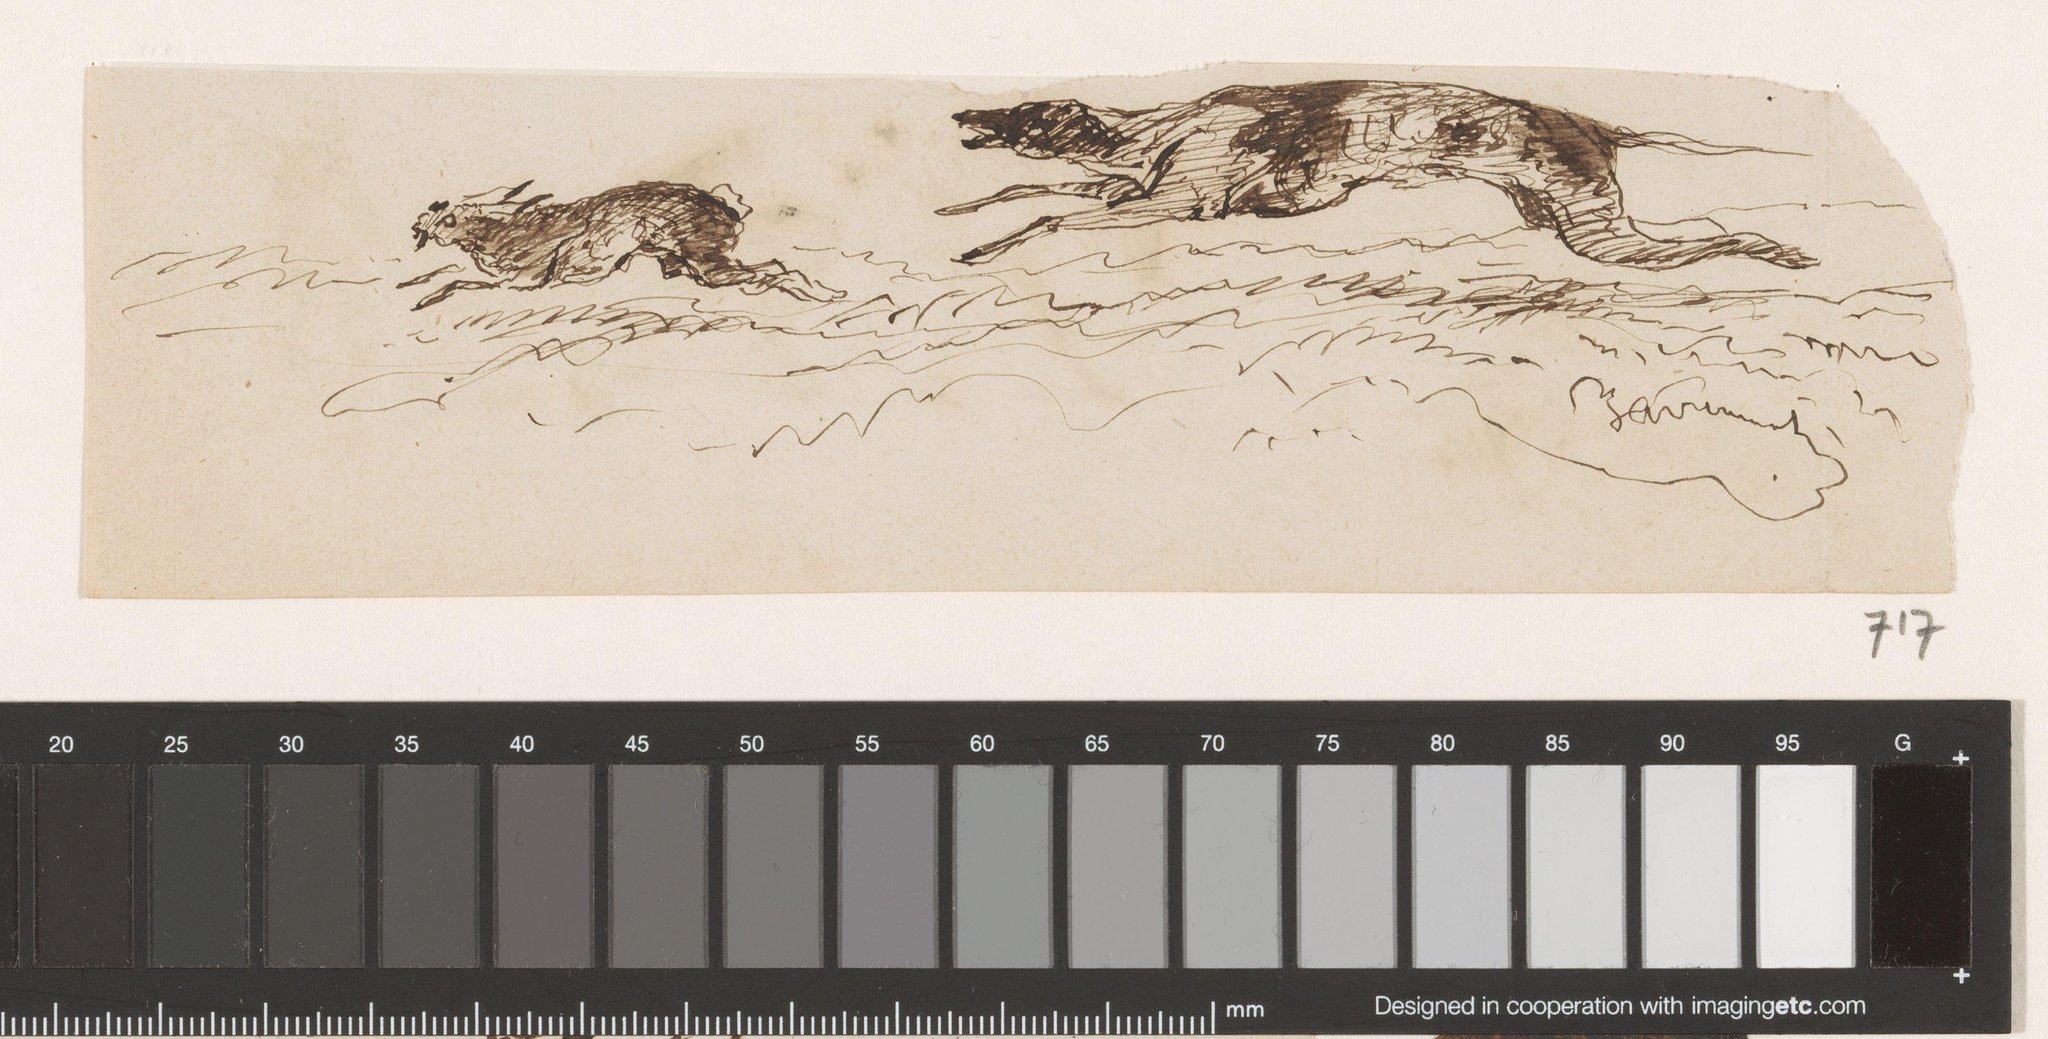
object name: drawing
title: Hond in achtervolging op haas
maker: johannes tavenraat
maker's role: draughtsman, painter, print maker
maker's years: 1809-1881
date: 1840-1880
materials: ink, paper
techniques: pen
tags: hunting dogs, rodents: hare, hare-hunting, rabbit-hunting, dog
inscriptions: signature: ‘Tavenraat’